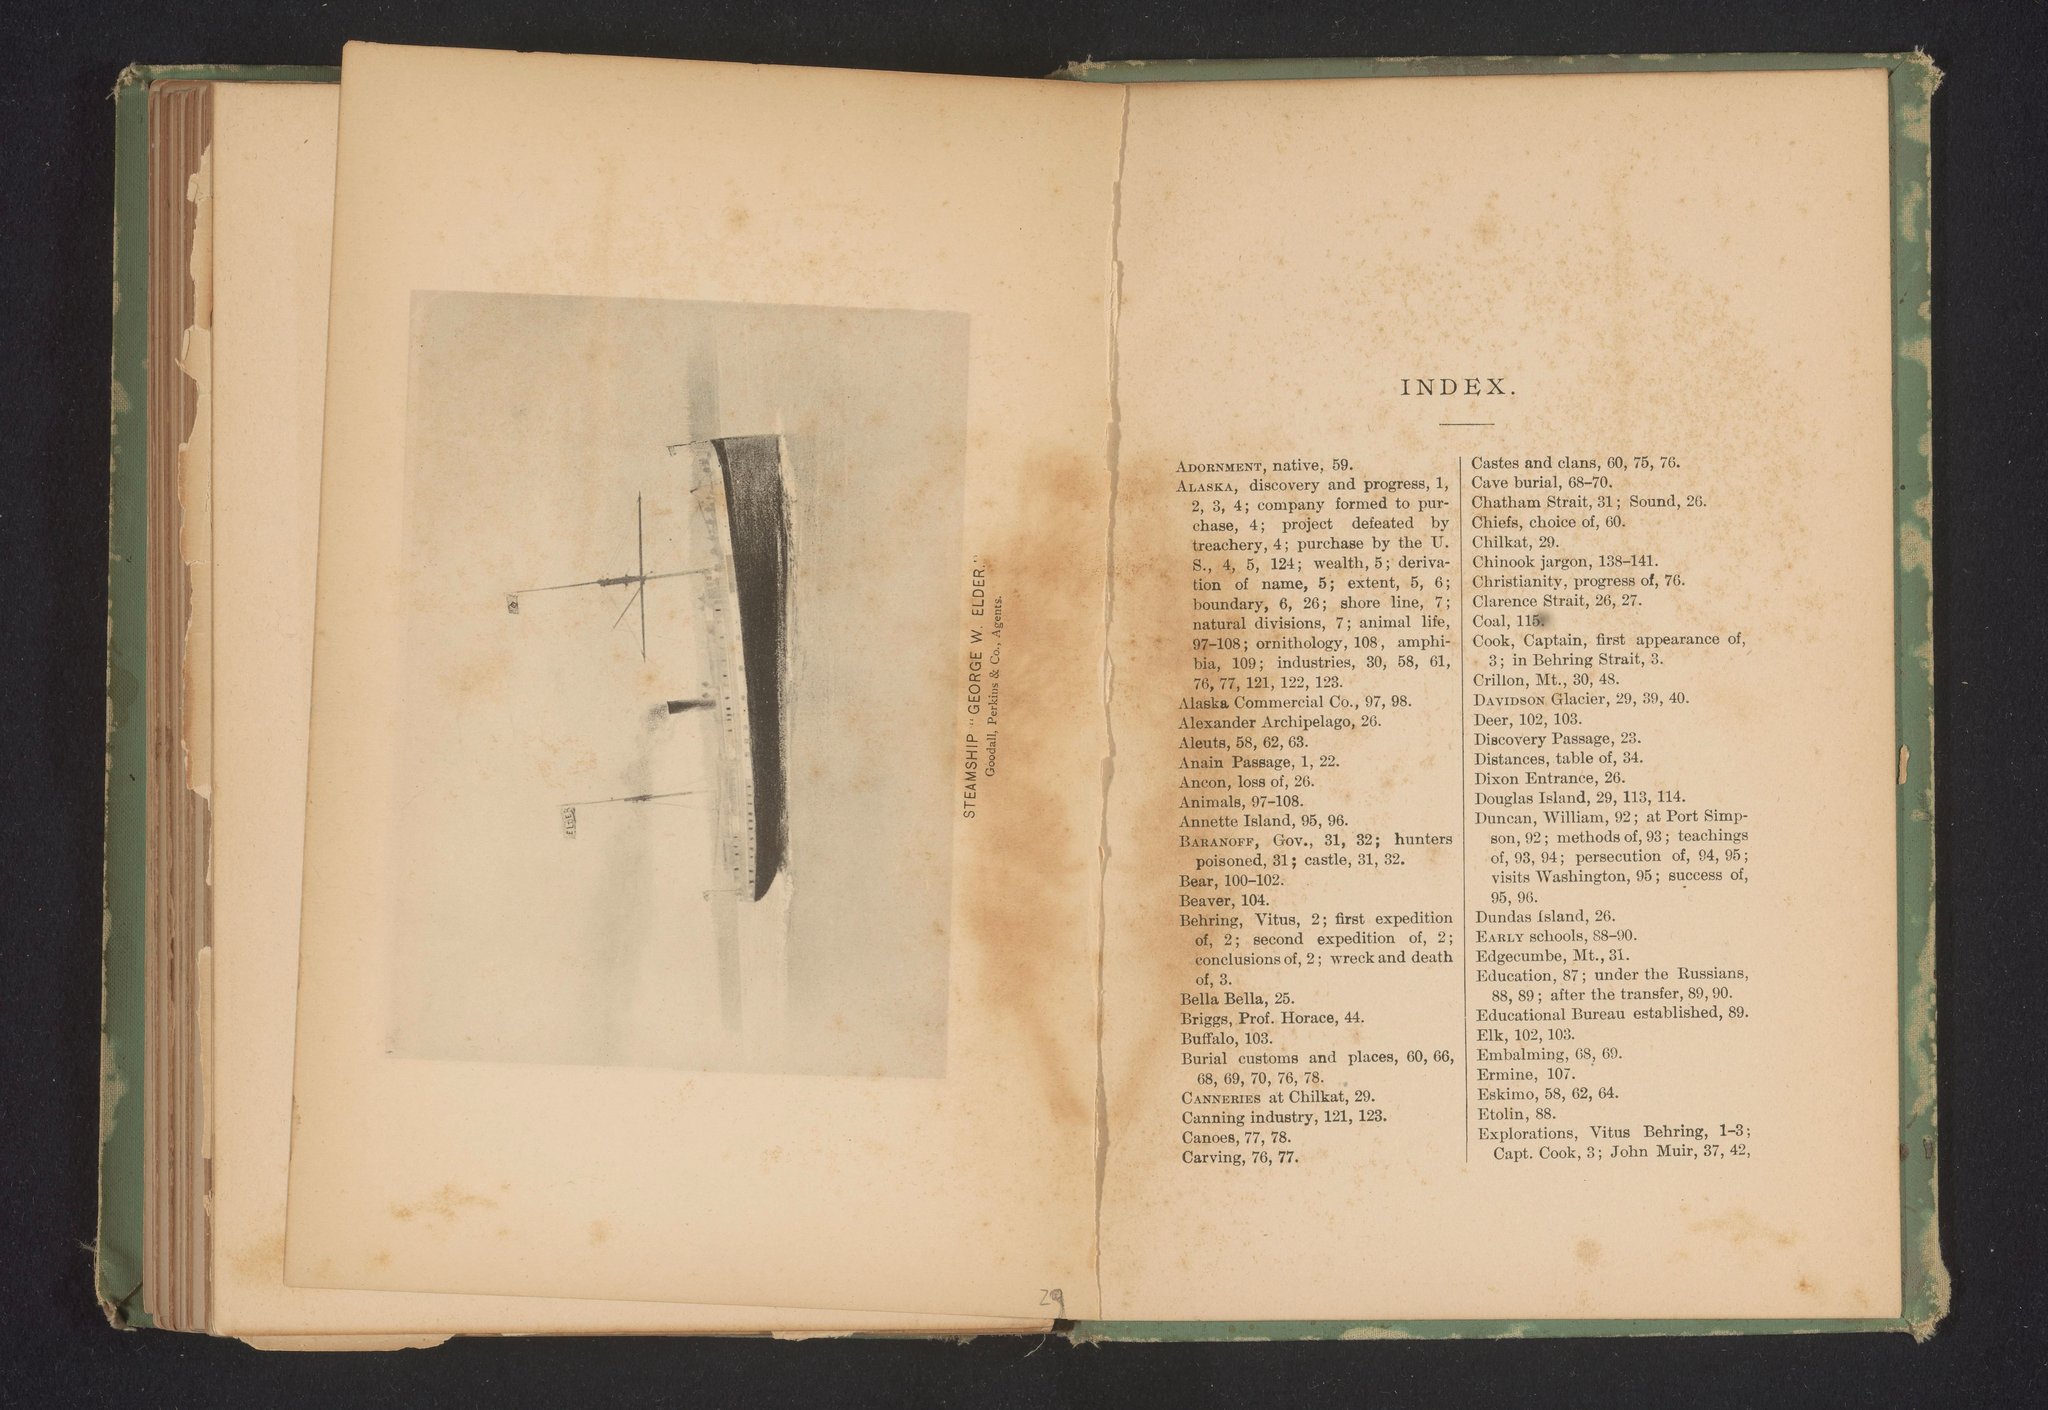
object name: page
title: Gezicht op het stoomschip de George W. Elder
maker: Anonymous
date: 1885-1890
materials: paper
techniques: photograph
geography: alaska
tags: ships (in general)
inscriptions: inscription: ‘Goodall, Perkins & Co., Agents.’